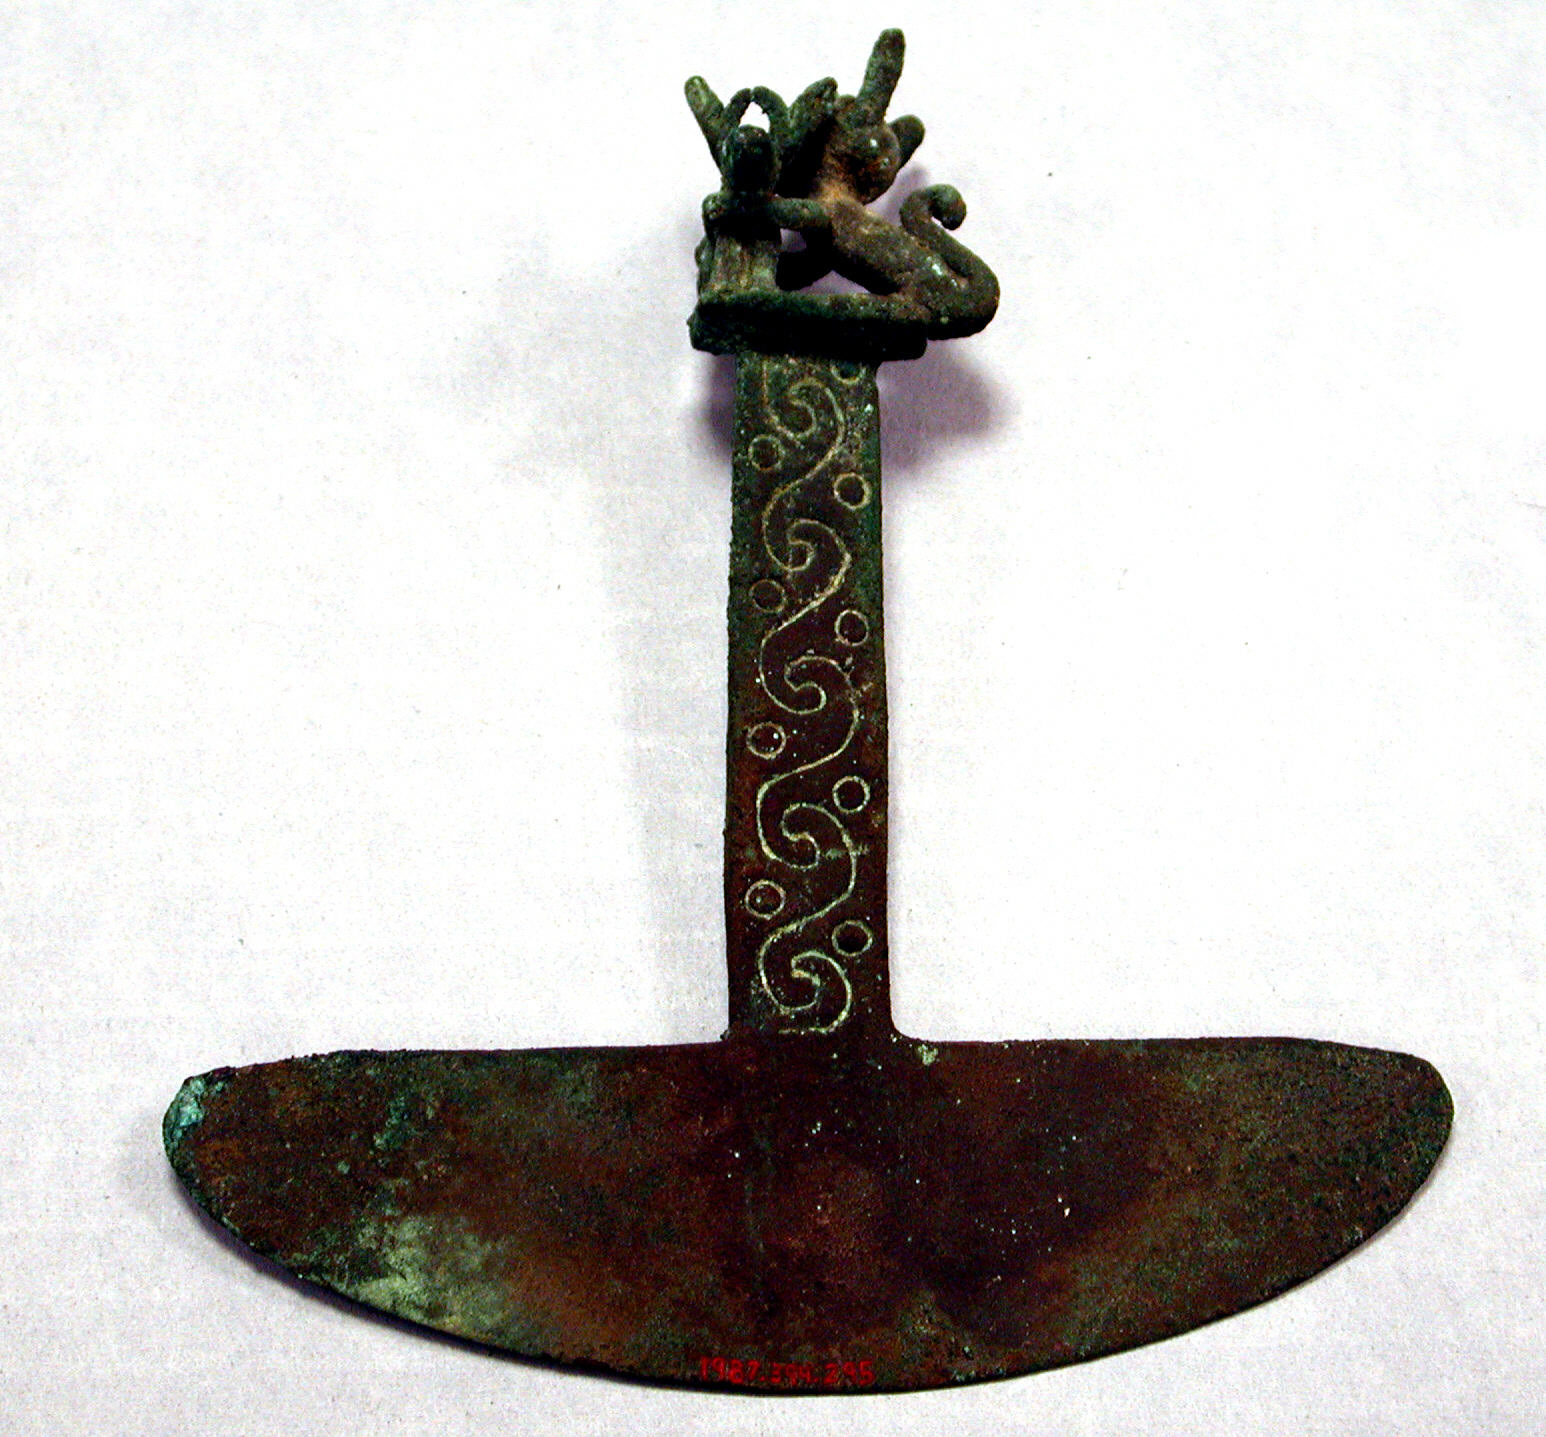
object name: knife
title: Ceremonial Knife (Tumi)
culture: chimú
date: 1101-1500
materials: copper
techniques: casting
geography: peru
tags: animals